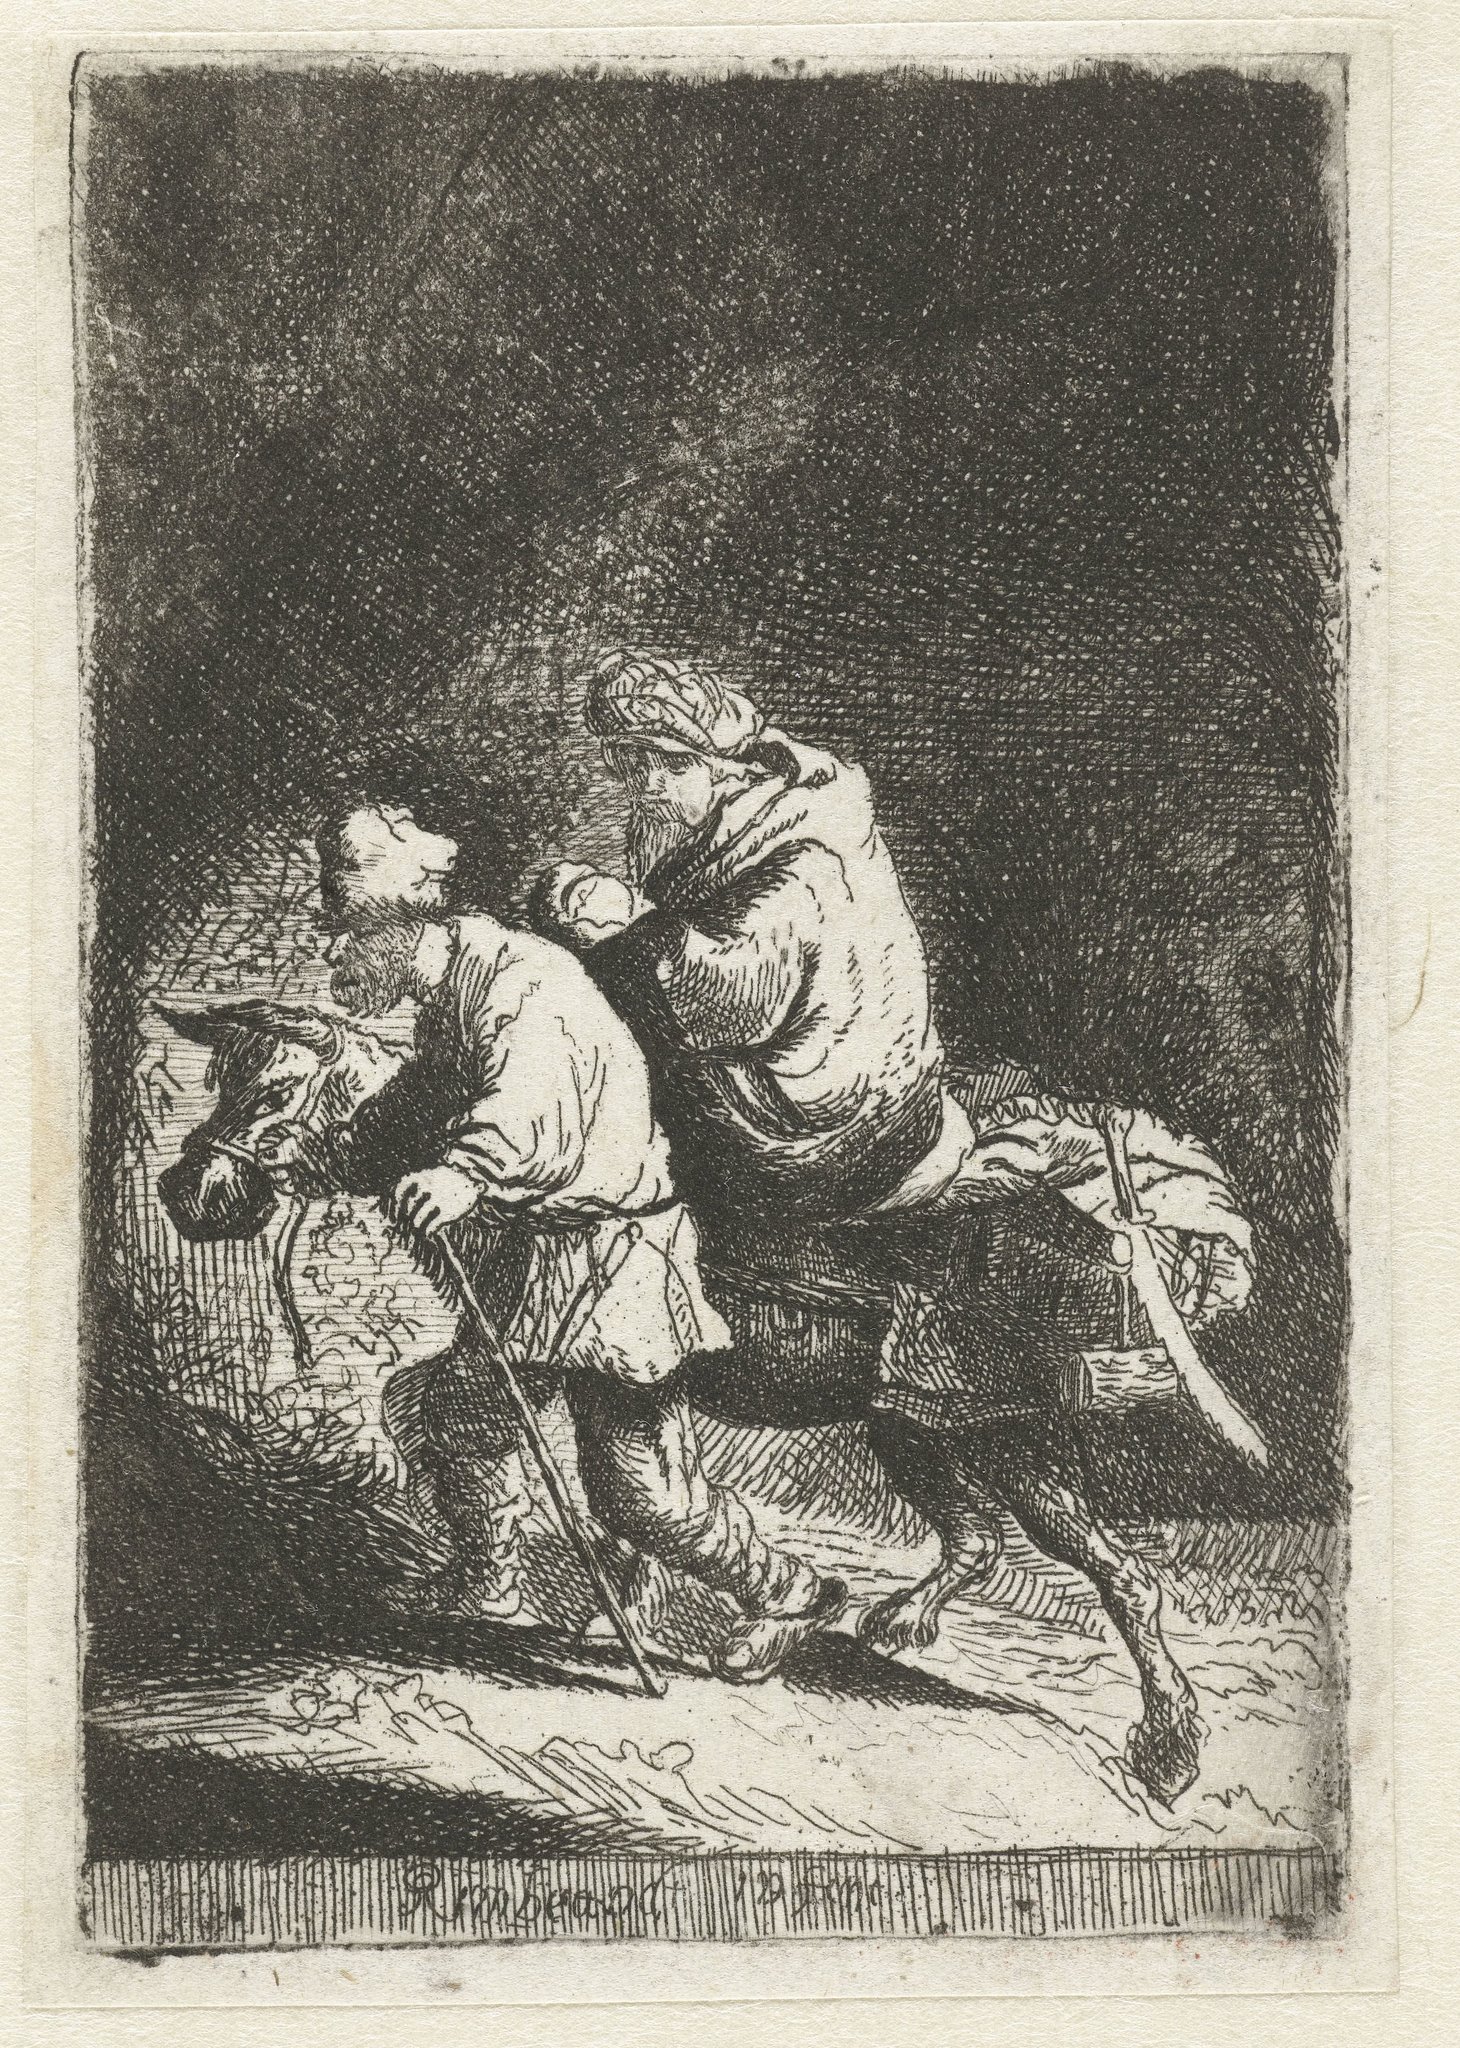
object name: print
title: The flight into Egypt: small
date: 1633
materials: paper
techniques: etching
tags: the flight into egypt: mary, joseph, the child (and sometimes others) on their way; mary usually riding on an ass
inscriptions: collector's mark: Lugt 240